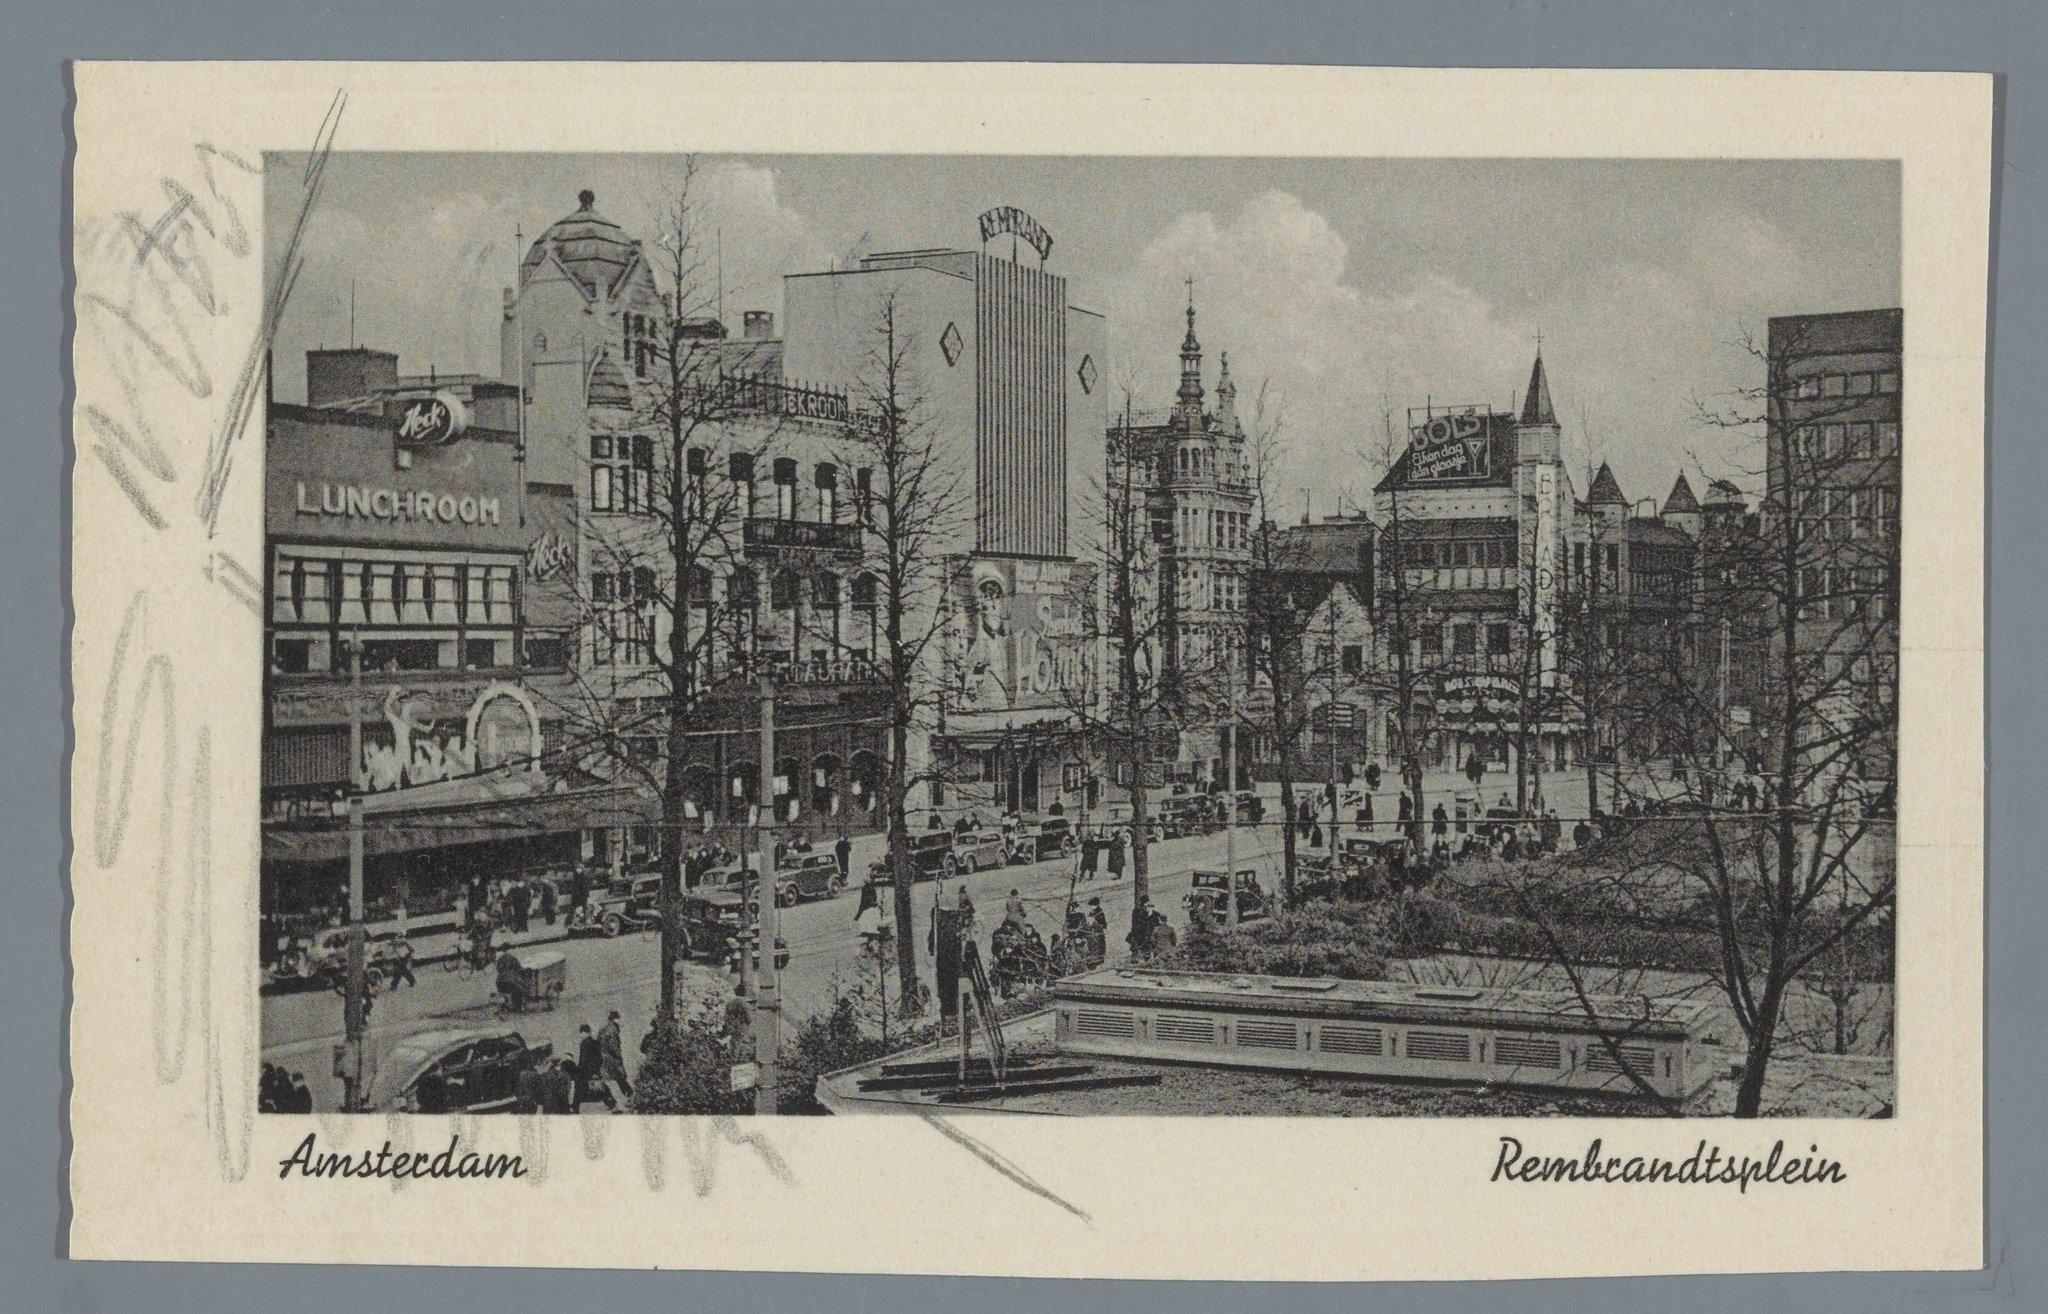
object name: photomechanical print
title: Amsterdam, Rembrandtsplein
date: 1940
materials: cardboard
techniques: photograph, writing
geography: amsterdam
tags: square, place, circus, etc.